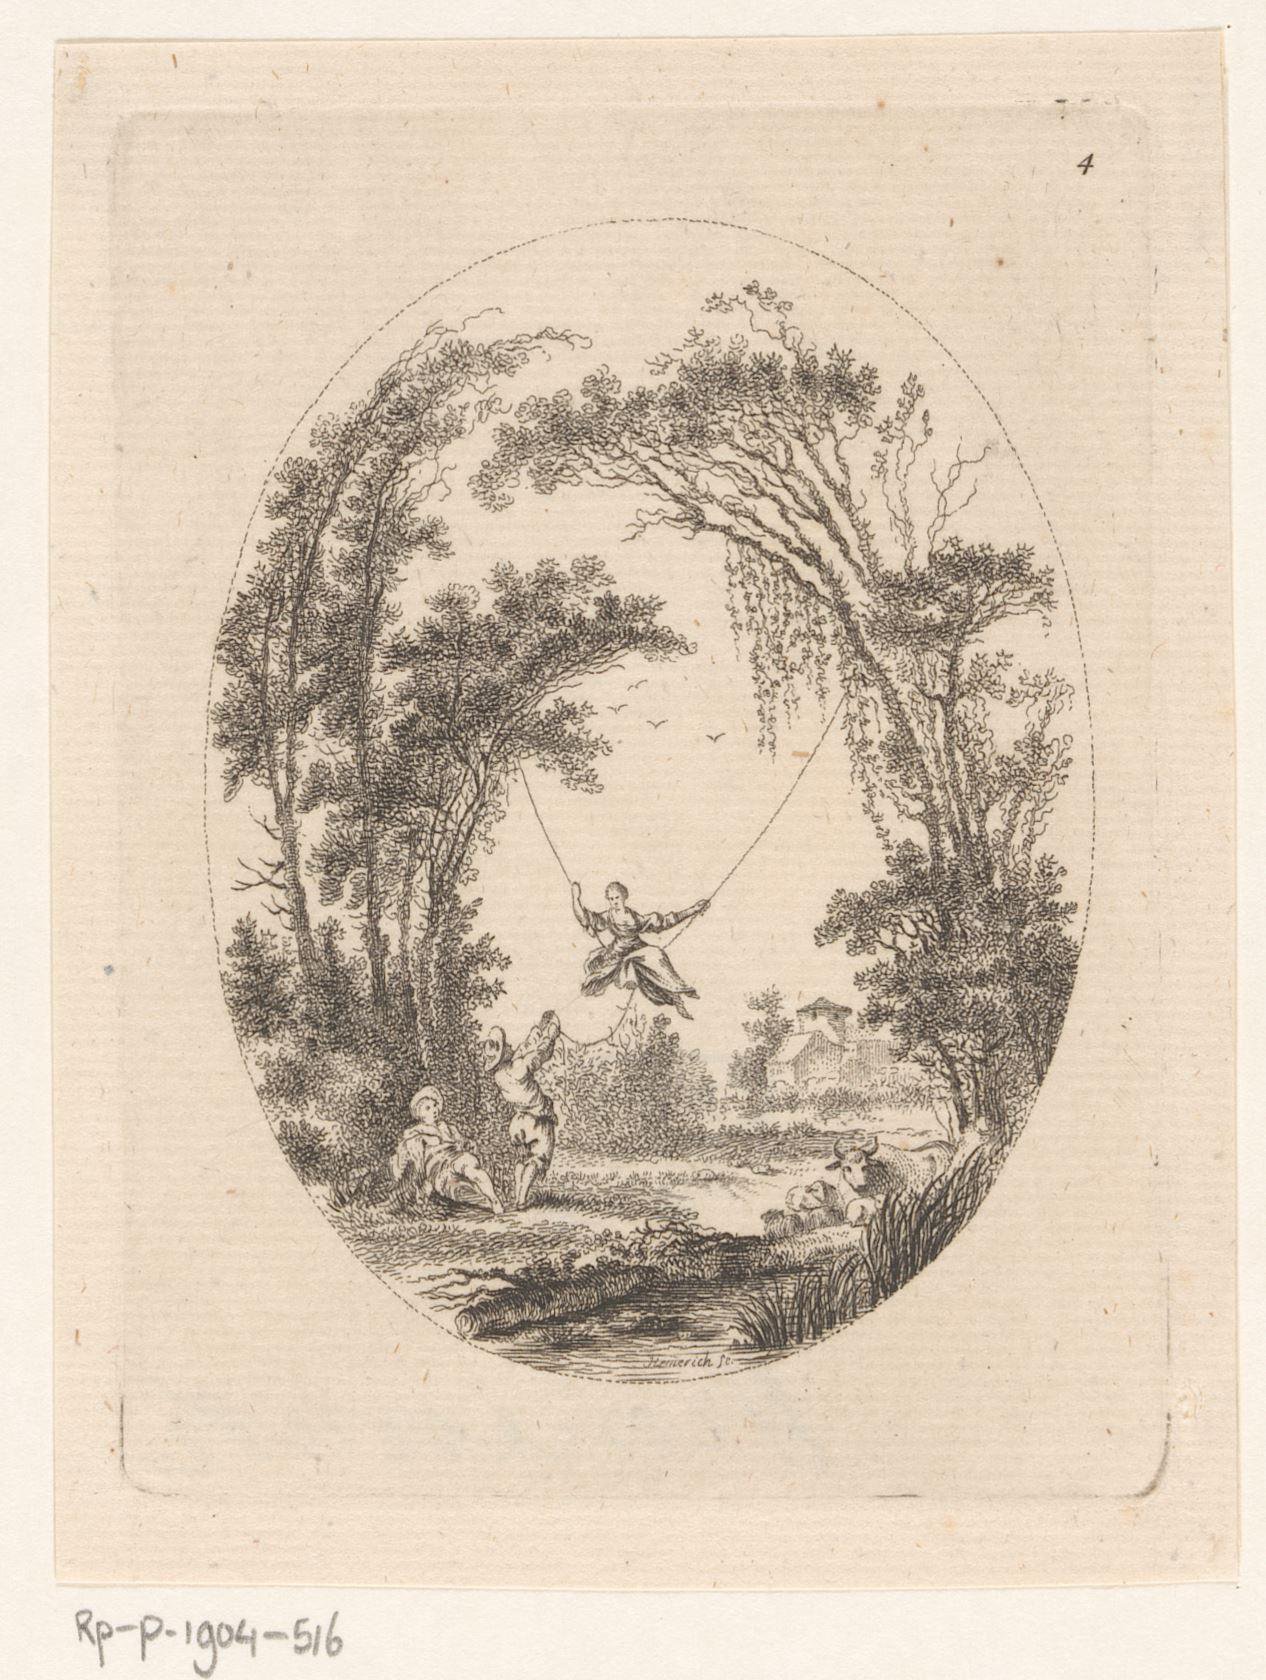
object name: print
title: Landschap met schommelende vrouw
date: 1758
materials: paper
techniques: etching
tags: landscapes, swing, rural life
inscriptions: collector's mark: Lugt 2228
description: Onderdeel van een serie van vier prenten over het landelijke leven in medaillonvorm.